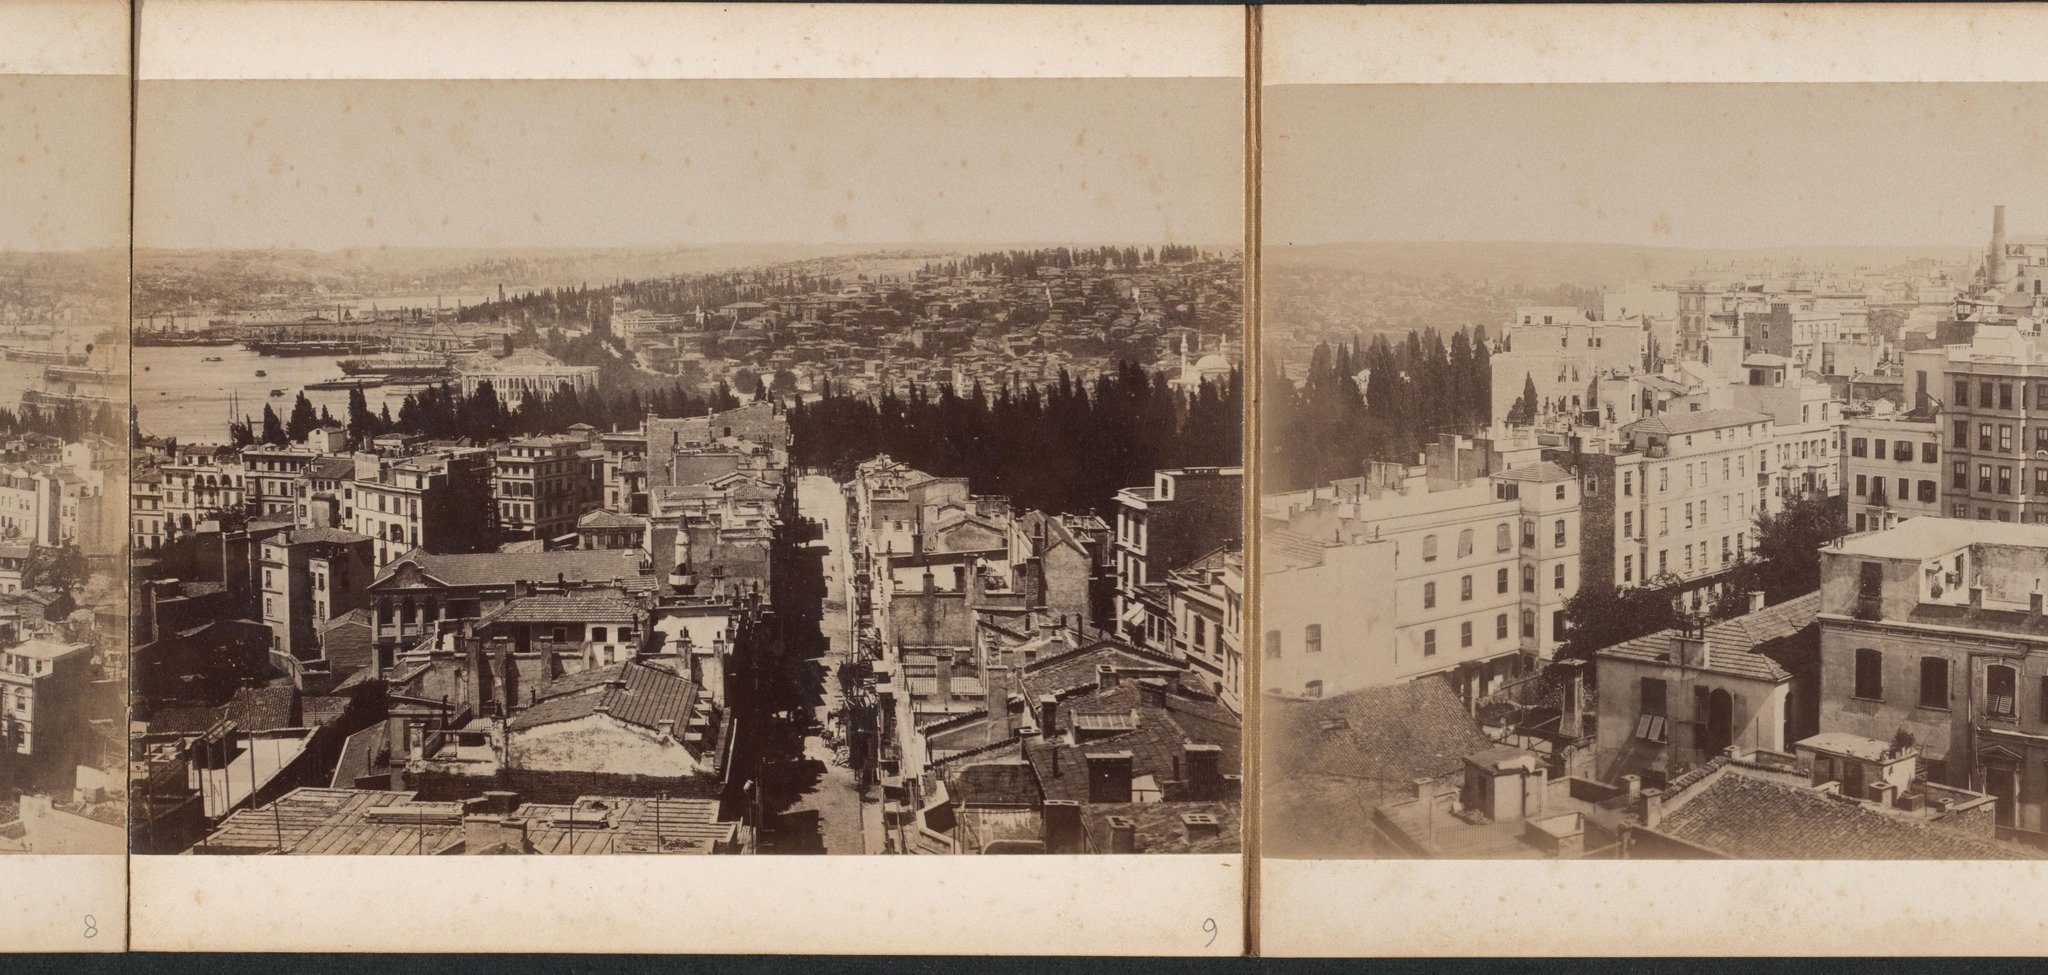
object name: photograph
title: Gezicht op stadswijken van Istanbul en de oevers van de Gouden Hoorn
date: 1890-1900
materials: cardboard, paper, photographic support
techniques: albumen print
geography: istanbul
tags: harbour, straits, narrows, trees, roof (of house or building), ships (in general), temple, shrine ~ islam, mohammedanism, pier, quay, wharf, façade (of house or building), prospect of city, town panorama, silhouette of city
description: Onderdeel van Panorama van Istanbul en de Bosporus, foto 9 van 10.